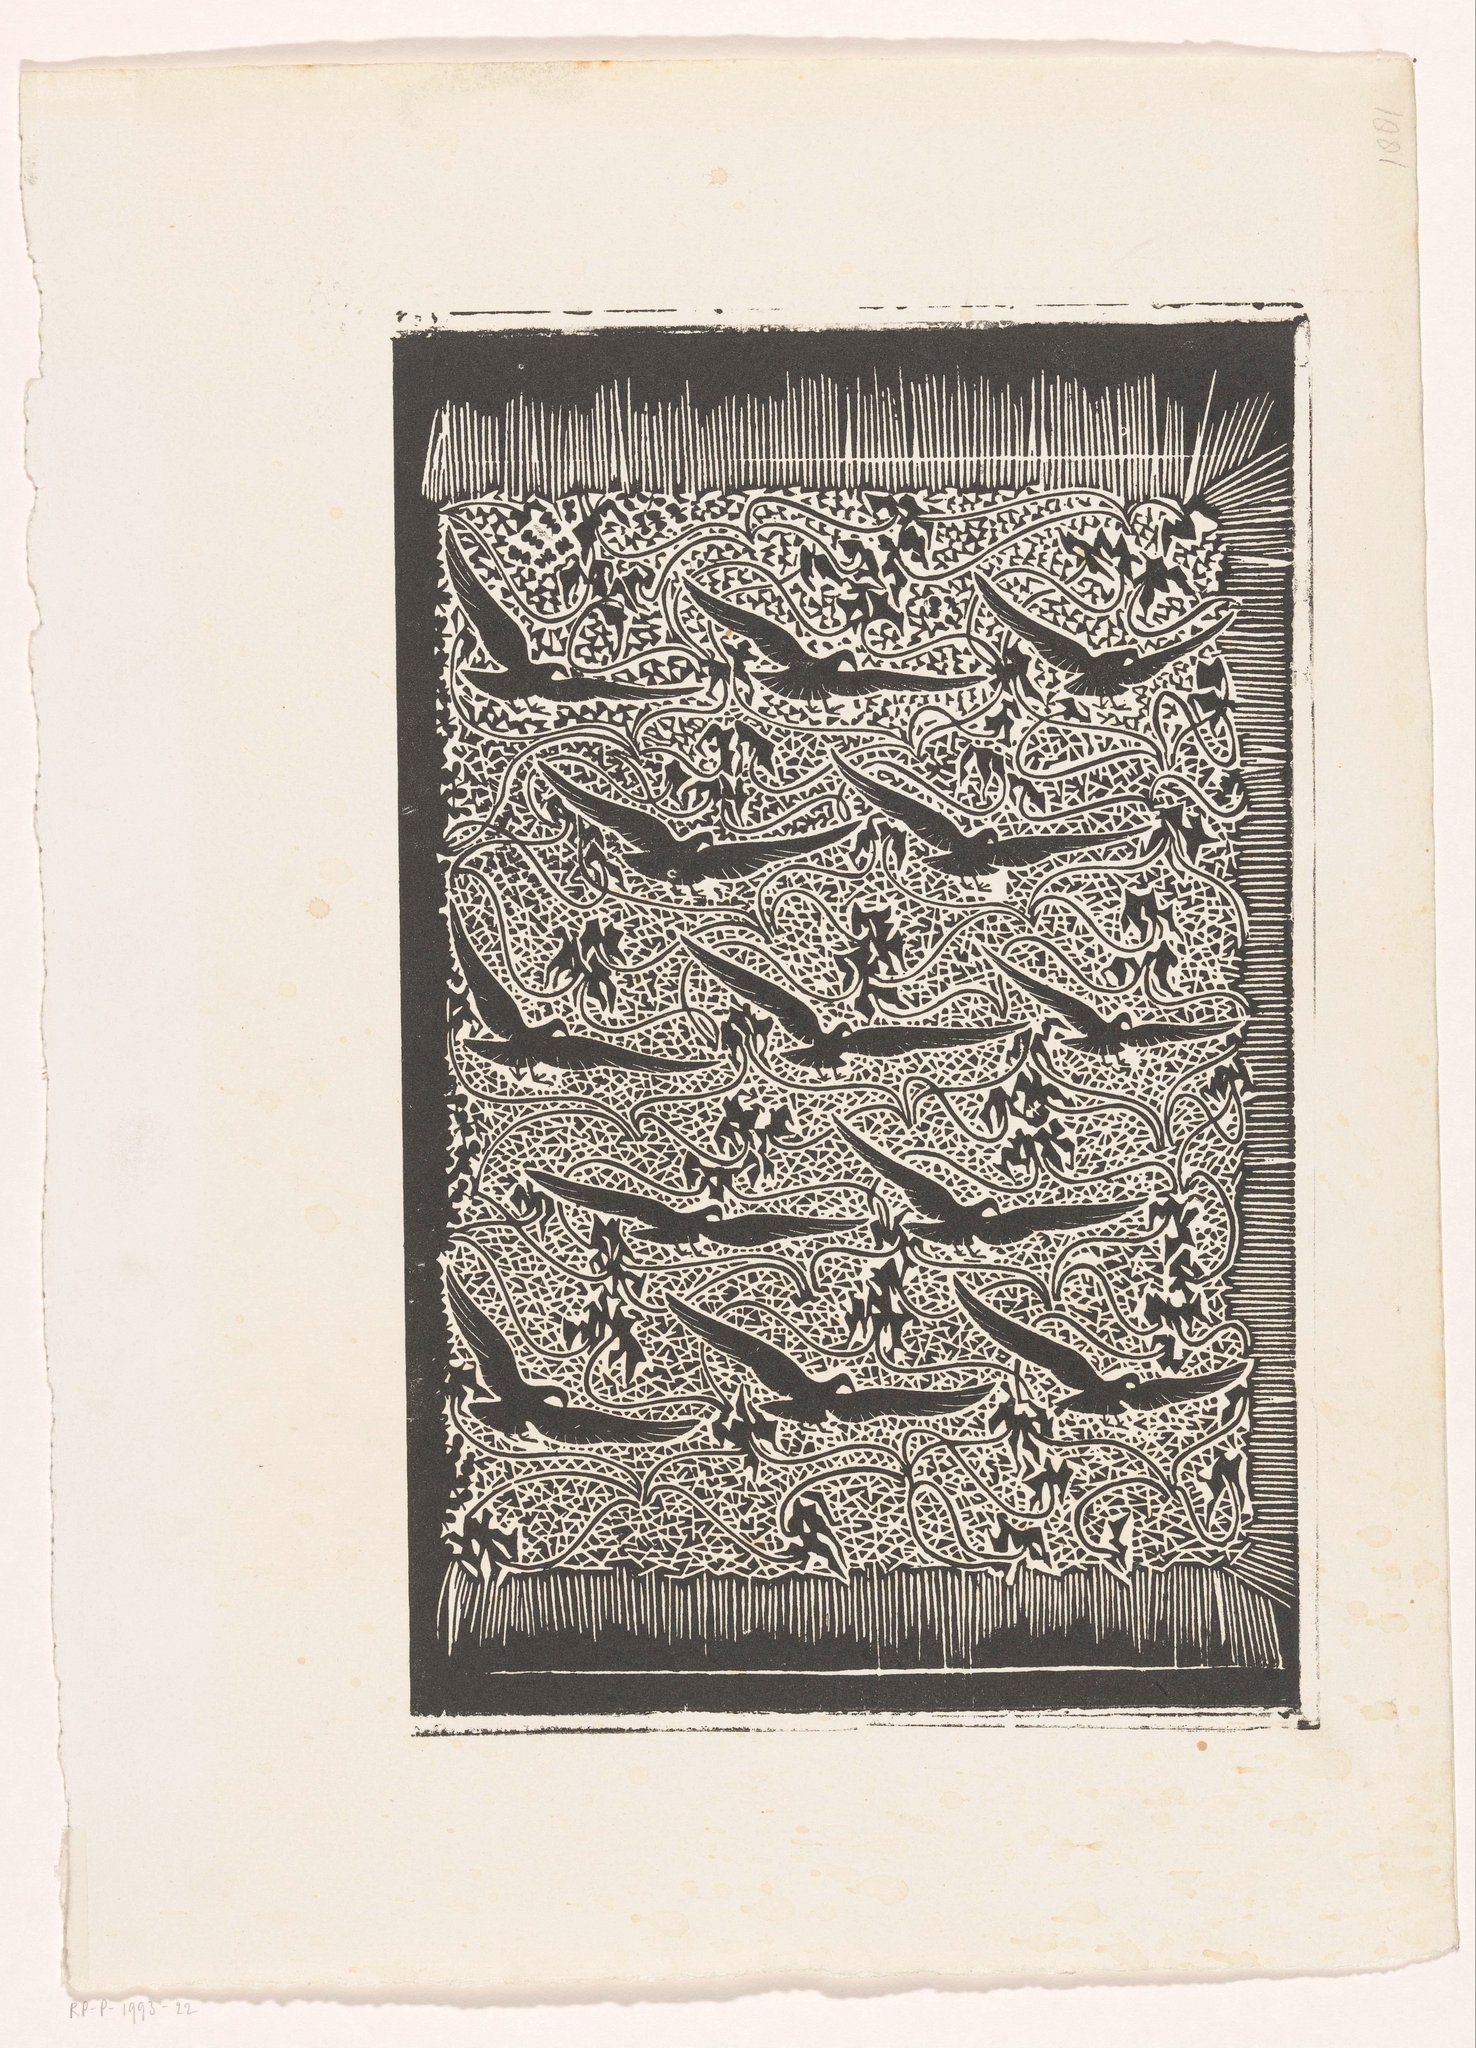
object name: print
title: Ontwerp voor het schutblad van de gebonden editie van 'Kunst en samenleving'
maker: gerrit willem dijsselhof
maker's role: designer, draughtsman, print maker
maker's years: 1866-1924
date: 1893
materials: paper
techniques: woodcut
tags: ornament derived from animal forms, groups of birds, ornament derived from plant forms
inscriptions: collector's mark: Lugt 2228, collector's mark: Lugt 2760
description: Prent gebruikt voor: Crane, Walter [vertaling: Veth, Jan]. Kunst en samenleving. Amsterdam: Scheltema & Holkema’s Boekhandel, 1893.